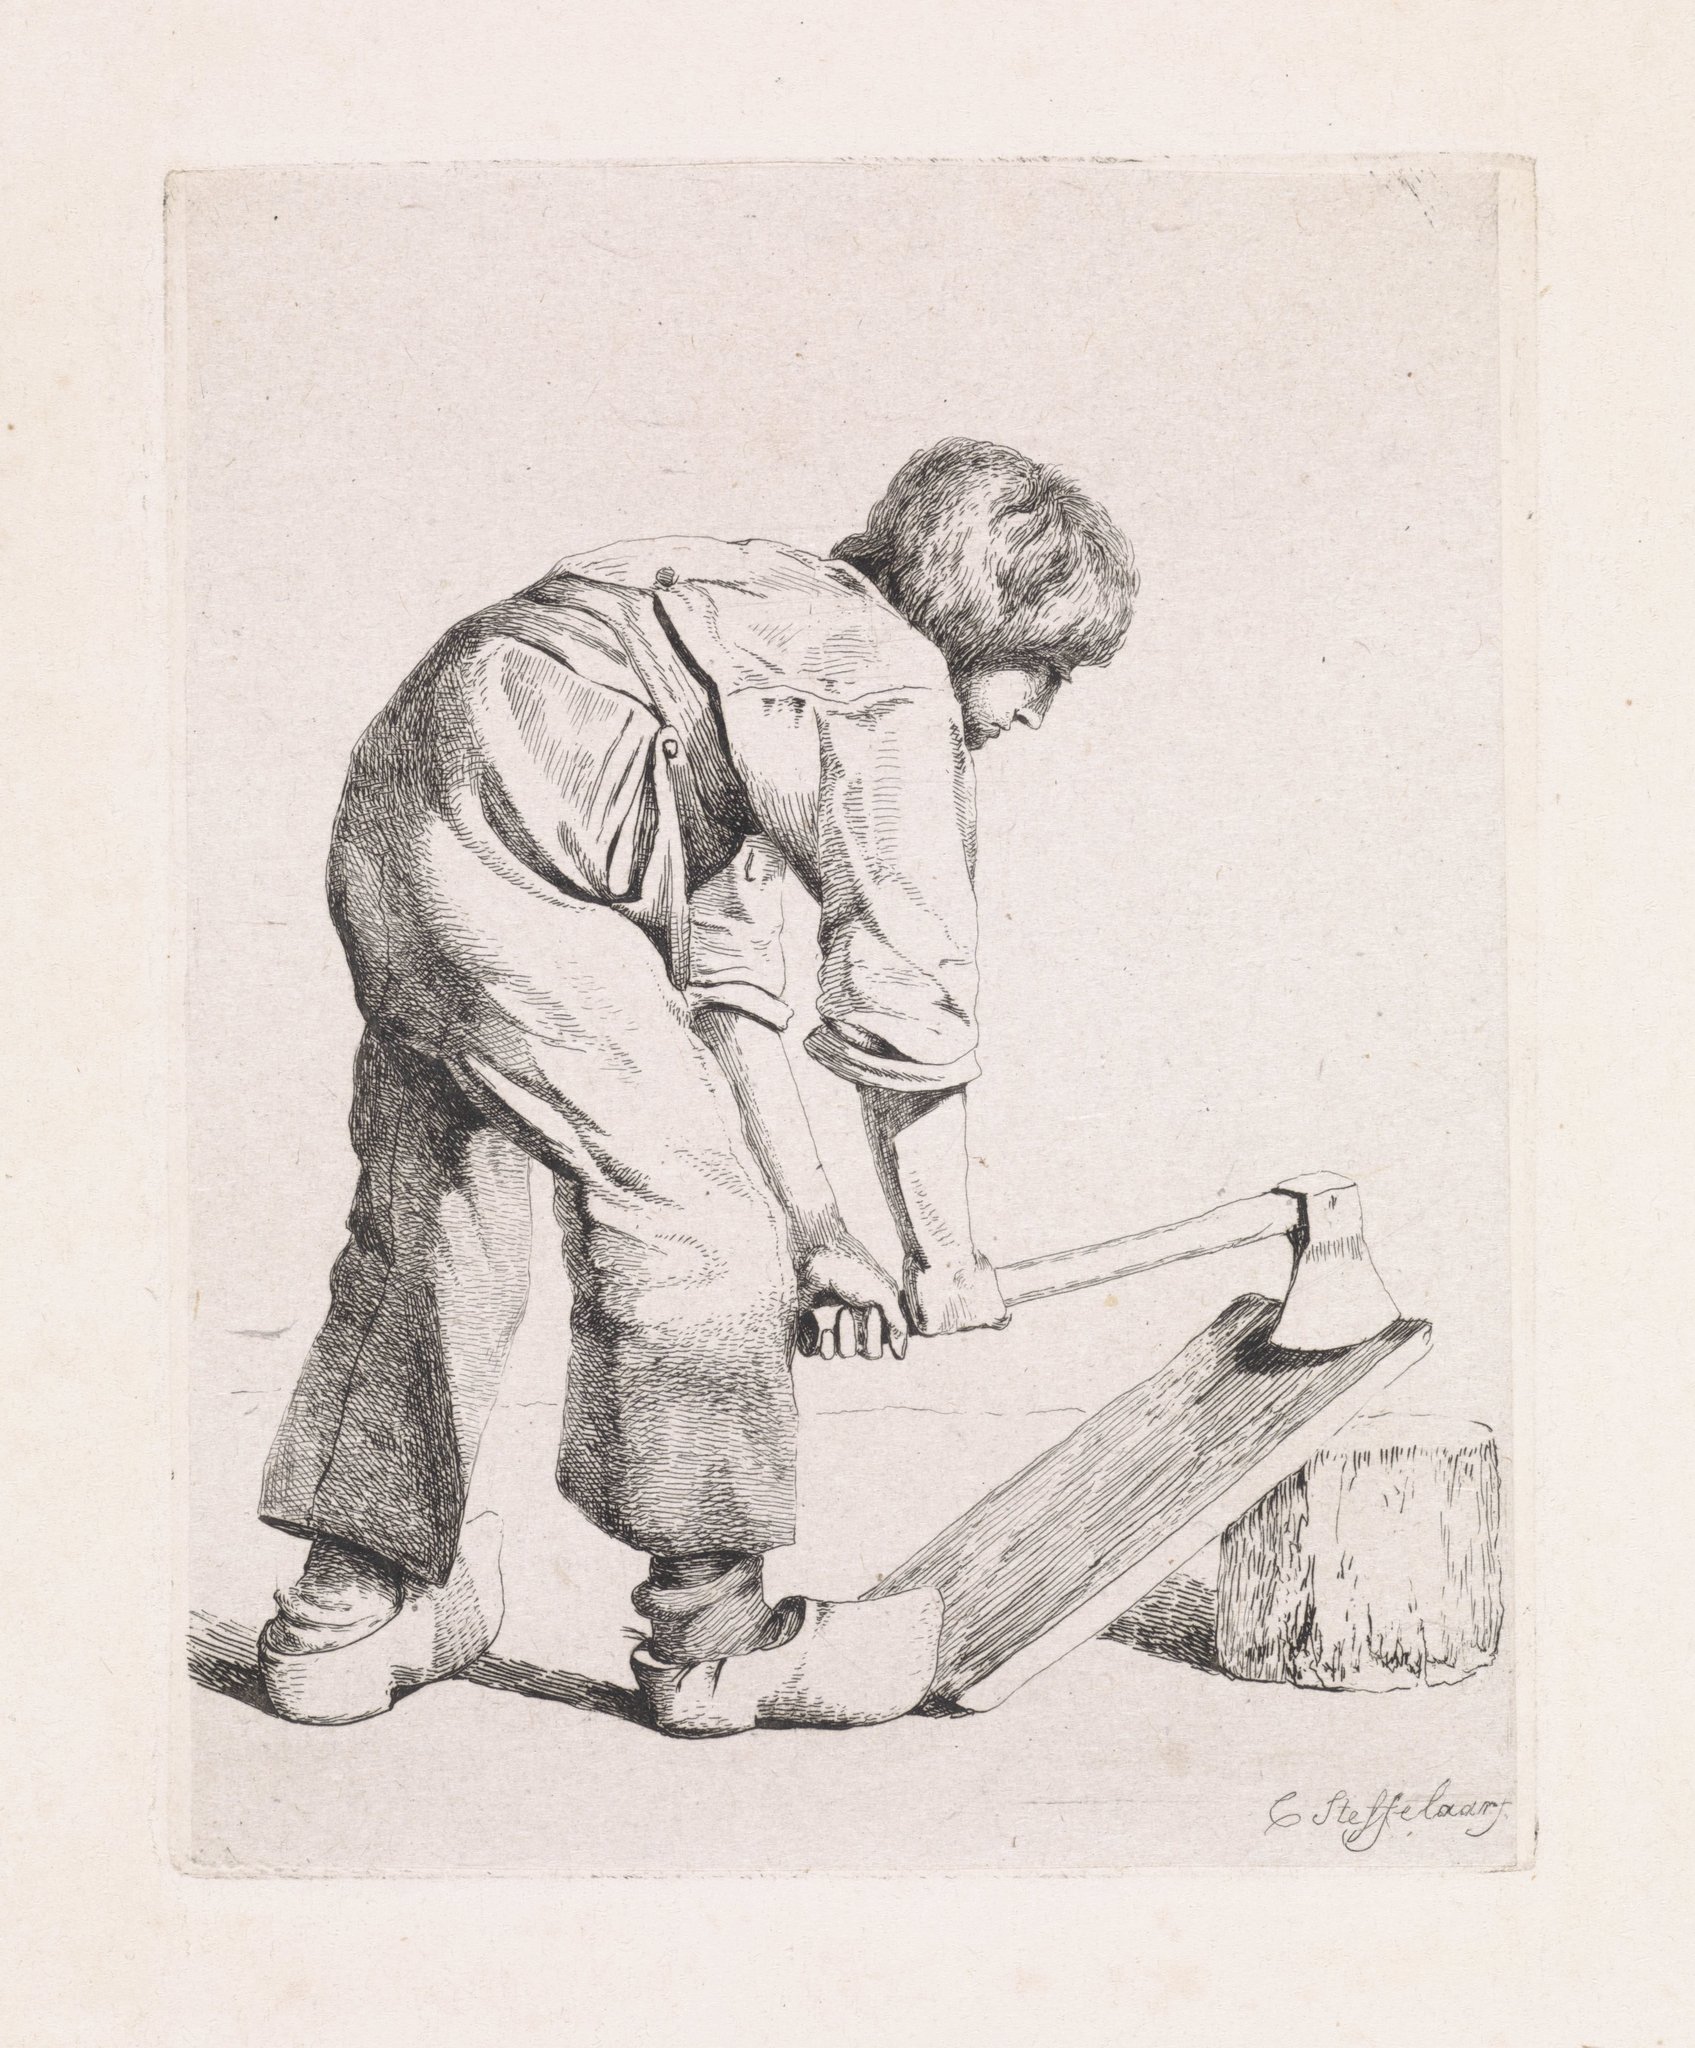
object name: print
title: Vierde suite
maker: cornelis steffelaar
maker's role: draughtsman, painter, print maker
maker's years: 1797-1861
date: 1807-1861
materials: paper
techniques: etching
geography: amsterdam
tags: wooden shoes, clogs, tools, aids, implements ~ crafts and industries: axe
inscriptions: collector's mark: Lugt 2228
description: Een man op klompen klooft hout met een bijl.